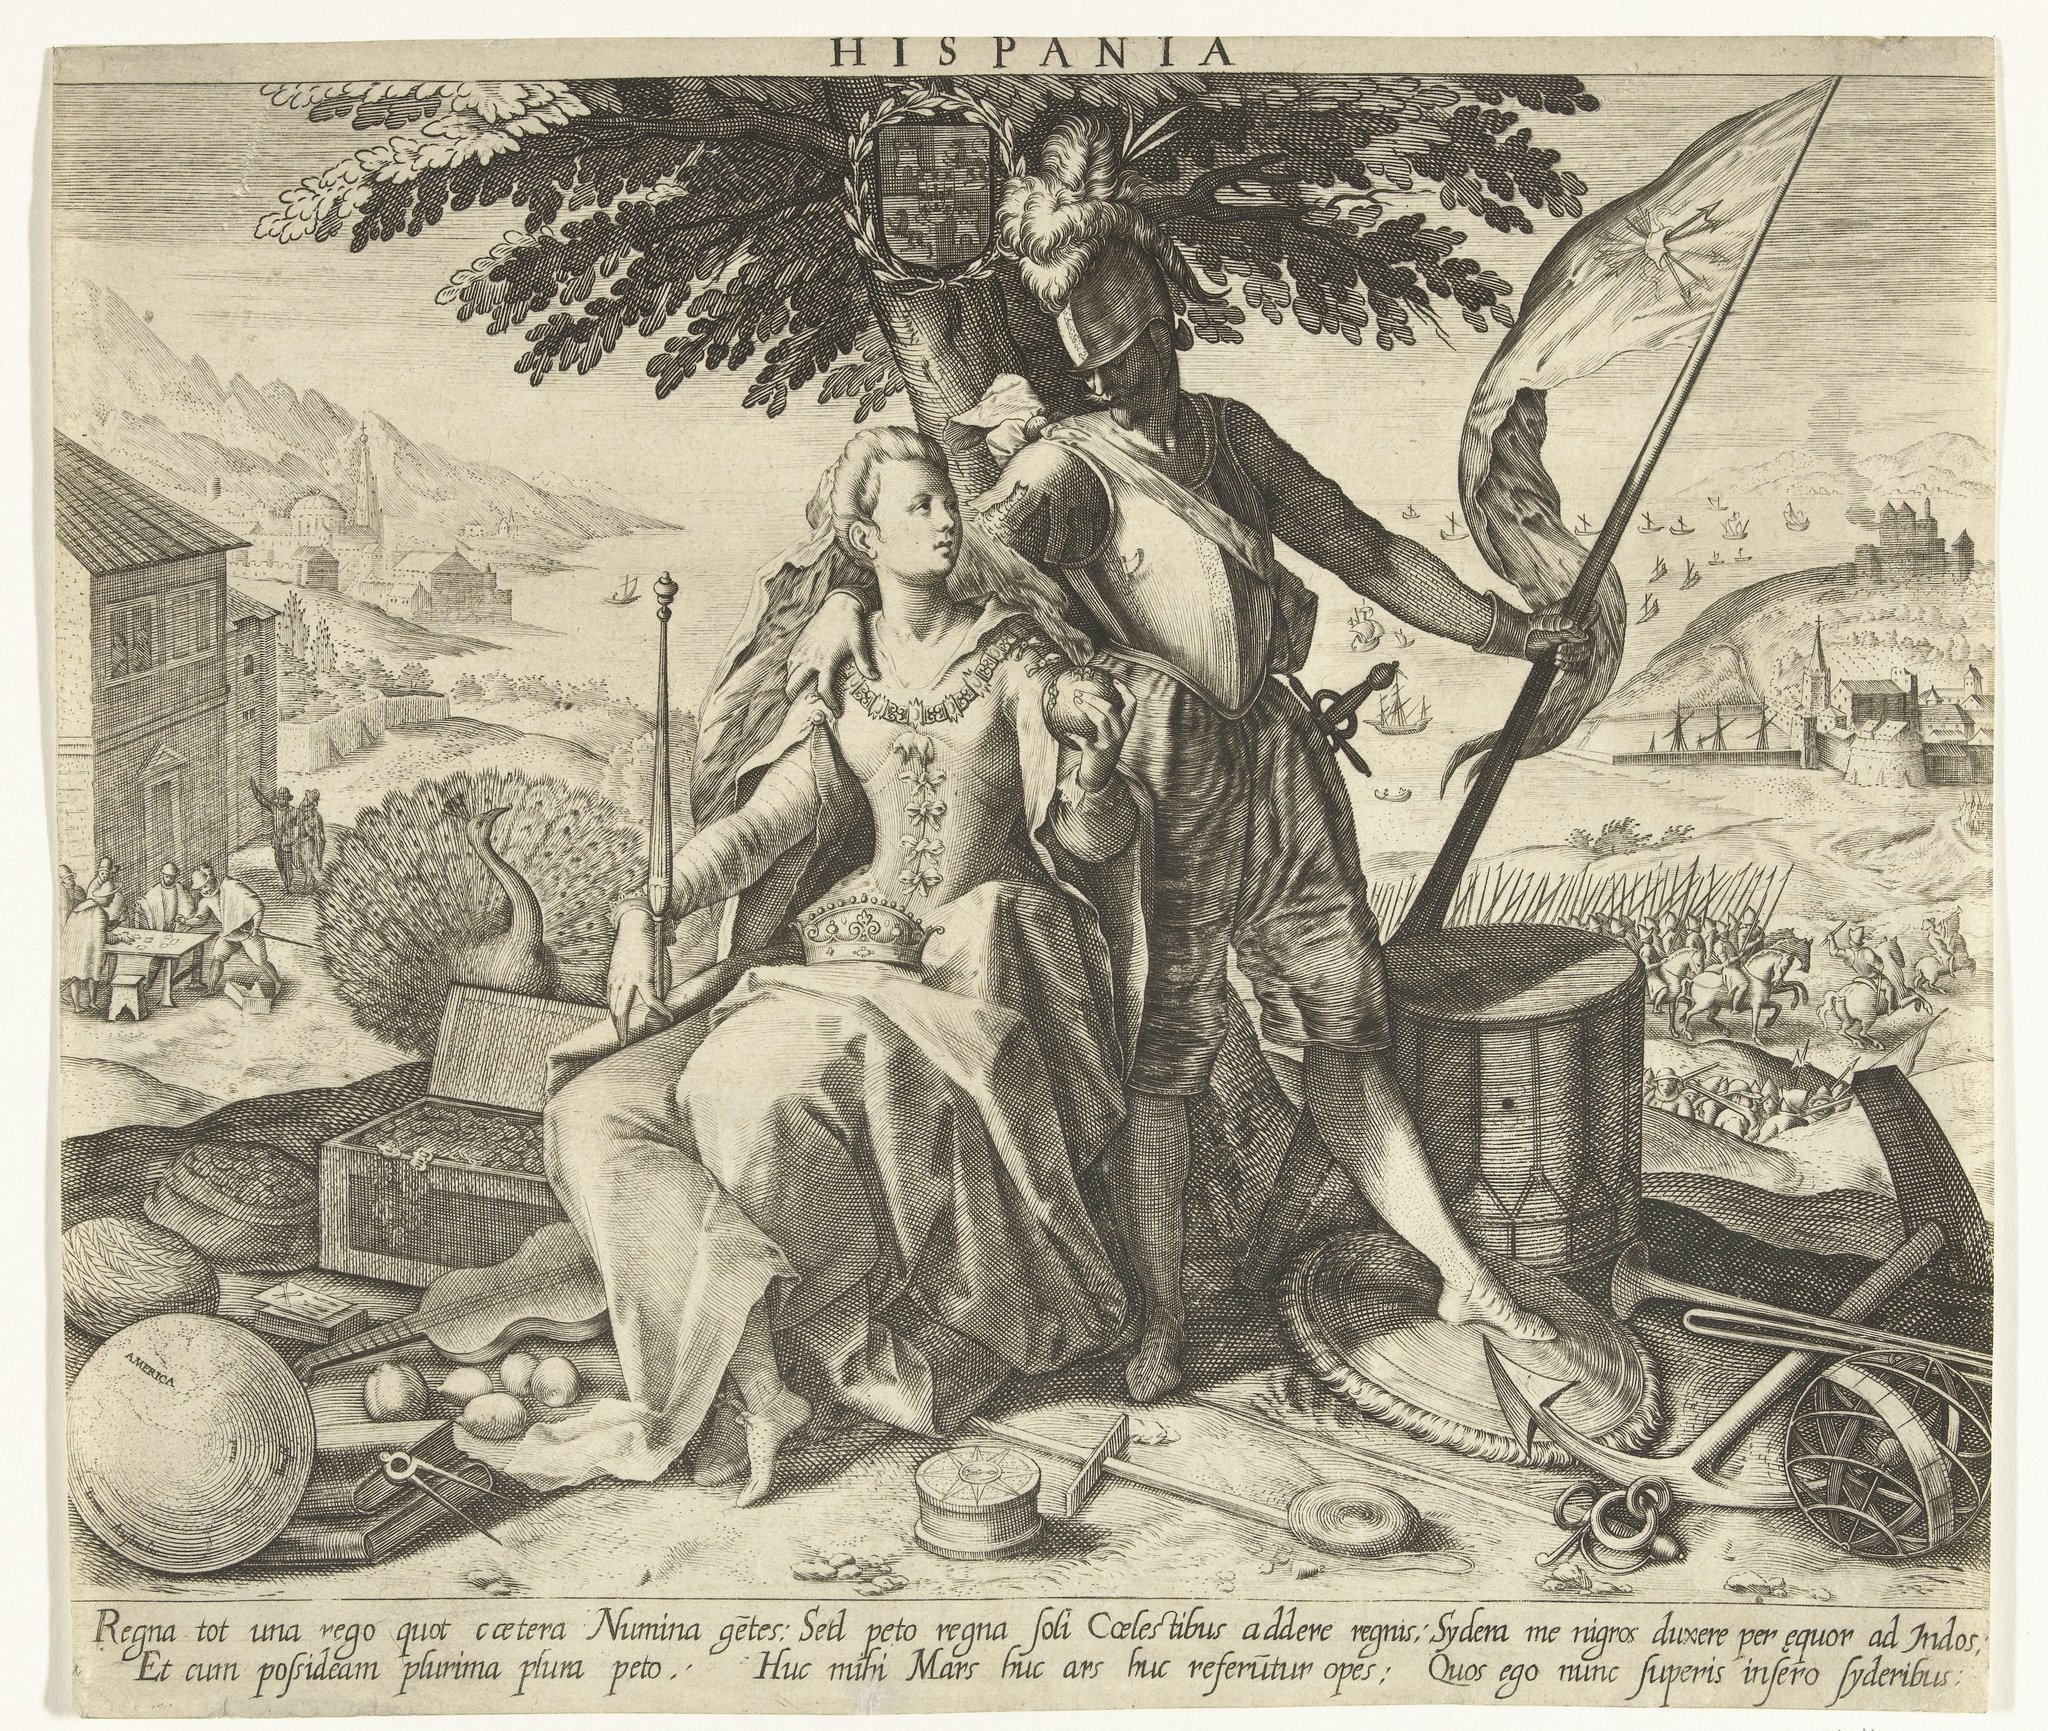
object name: print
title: Allegorieën van Europese landen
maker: robert bossart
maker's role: print maker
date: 1575-1599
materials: paper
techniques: engraving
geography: southern netherlands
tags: (story of) mars (ares), personifications of countries, nations, states, districts, etc., ornamental birds: peacock, symbols, allegories of war; 'guerra' (ripa), globe, position-finding at sea; nautical instruments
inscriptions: collector's mark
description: Hispania zit onder een boom, naast haar staat de oorlogsgod Mars. Op de grond liggen attributen van Hispania: een wereldbol met erop Amerika, een schatkist met geld, een kompas en anker als symbool voor de zeemacht. Op de achtergrond is een leger te zien dat ten strijde trekt. In een baai liggen schepen. Onder de voorstelling een verklarend vers in het Latijn.